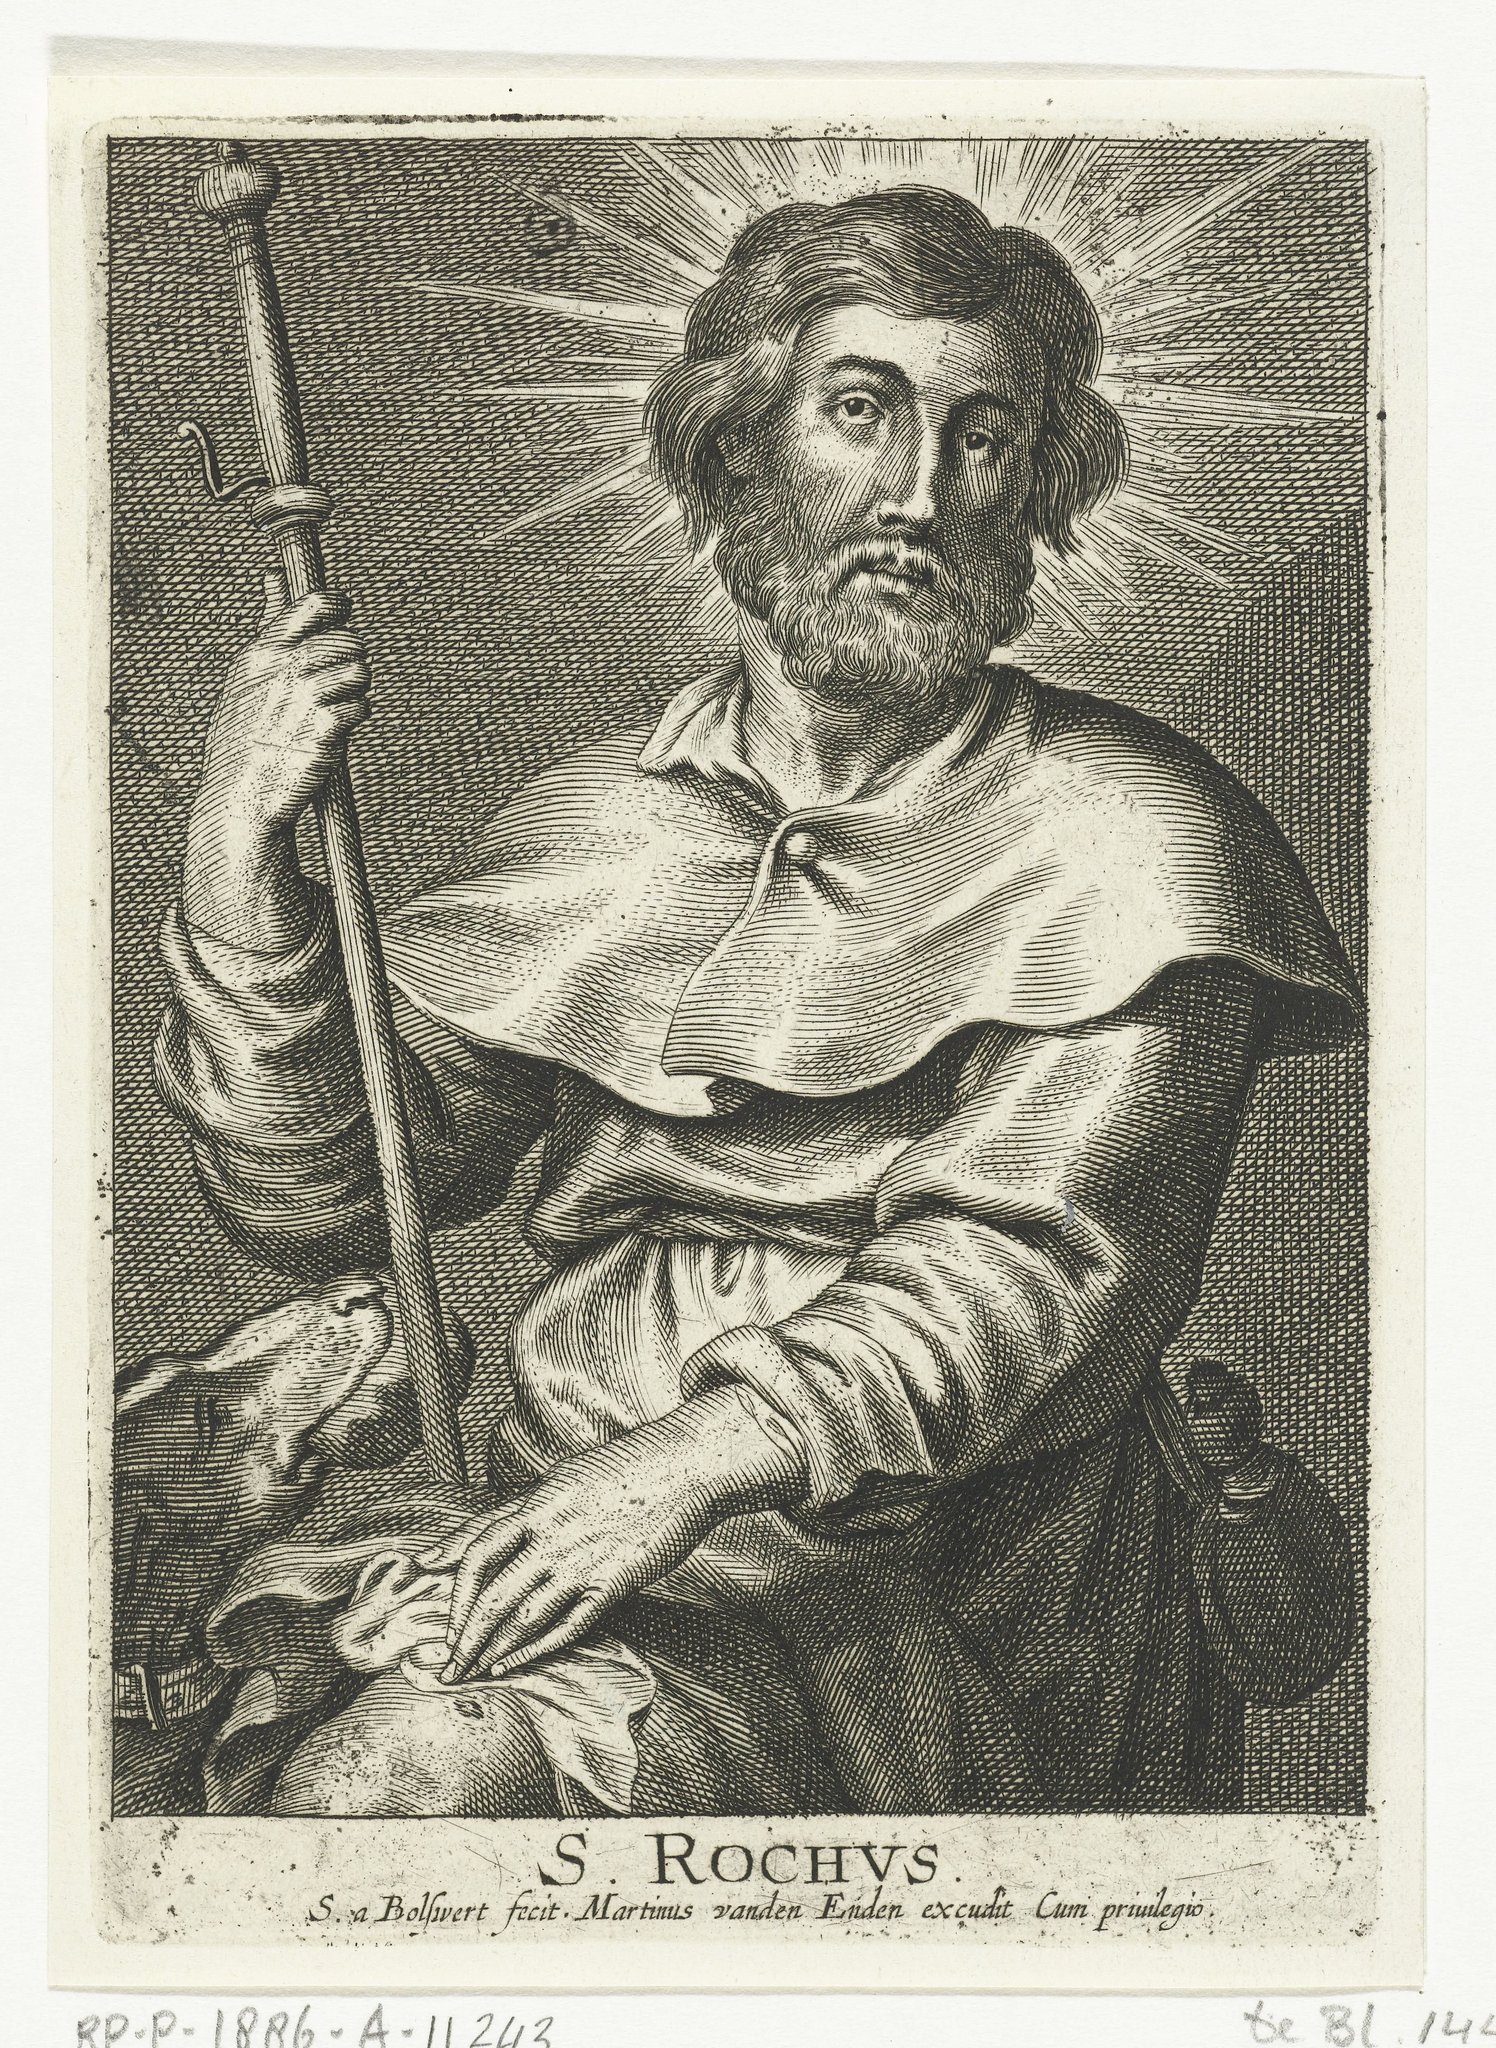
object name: print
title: Heilige Rochus als pelgrim met zweer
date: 1596-1659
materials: paper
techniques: engraving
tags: the confessor and pilgrim roch(us) (rocco, rock) of montpellier; possible attributes: angel (with ointment box or spoon), dog (sometimes with loaf), (pointing at) plague-spot on thigh, pilgrim's shell, staff, hat and wallet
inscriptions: collector's mark: Lugt 2228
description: Prent uit serie Vélins met negentig prenten naar ontwerp van Peter Paul Rubens. In de bronnen vinden we uiteenlopende gegevens over aantal en samenstelling van de serie. Hollstein hanteert het aantal van negentig prenten. De reeks Vélins in de collectie van het RMA bevat verschillende staten afkomstig uit meerdere uitgaven welke moeilijk te duiden zijn. Sommige dragen het originele adres van Schelte Adamsz. Bolswert als graveur en uitgever, op andere exemplaren is deze naam verwijderd (duidelijk zichtbaar!) en vervangen door de naam Cornelis Galle (II). De prenten met de naam van uitgever Galle zijn vaak opgewerkt. We treffen nog een andere naam van een uitgever bij enkele prent aan: Martien van den Enden. Herkomst uit meerdere uitgaven spreekt ook uit afwijkende opschriften in Nederlands en Latijn en variaties op dezelfde thema's welke misschien nooit langs elkaar in dezelfde serie gebruikt werden.